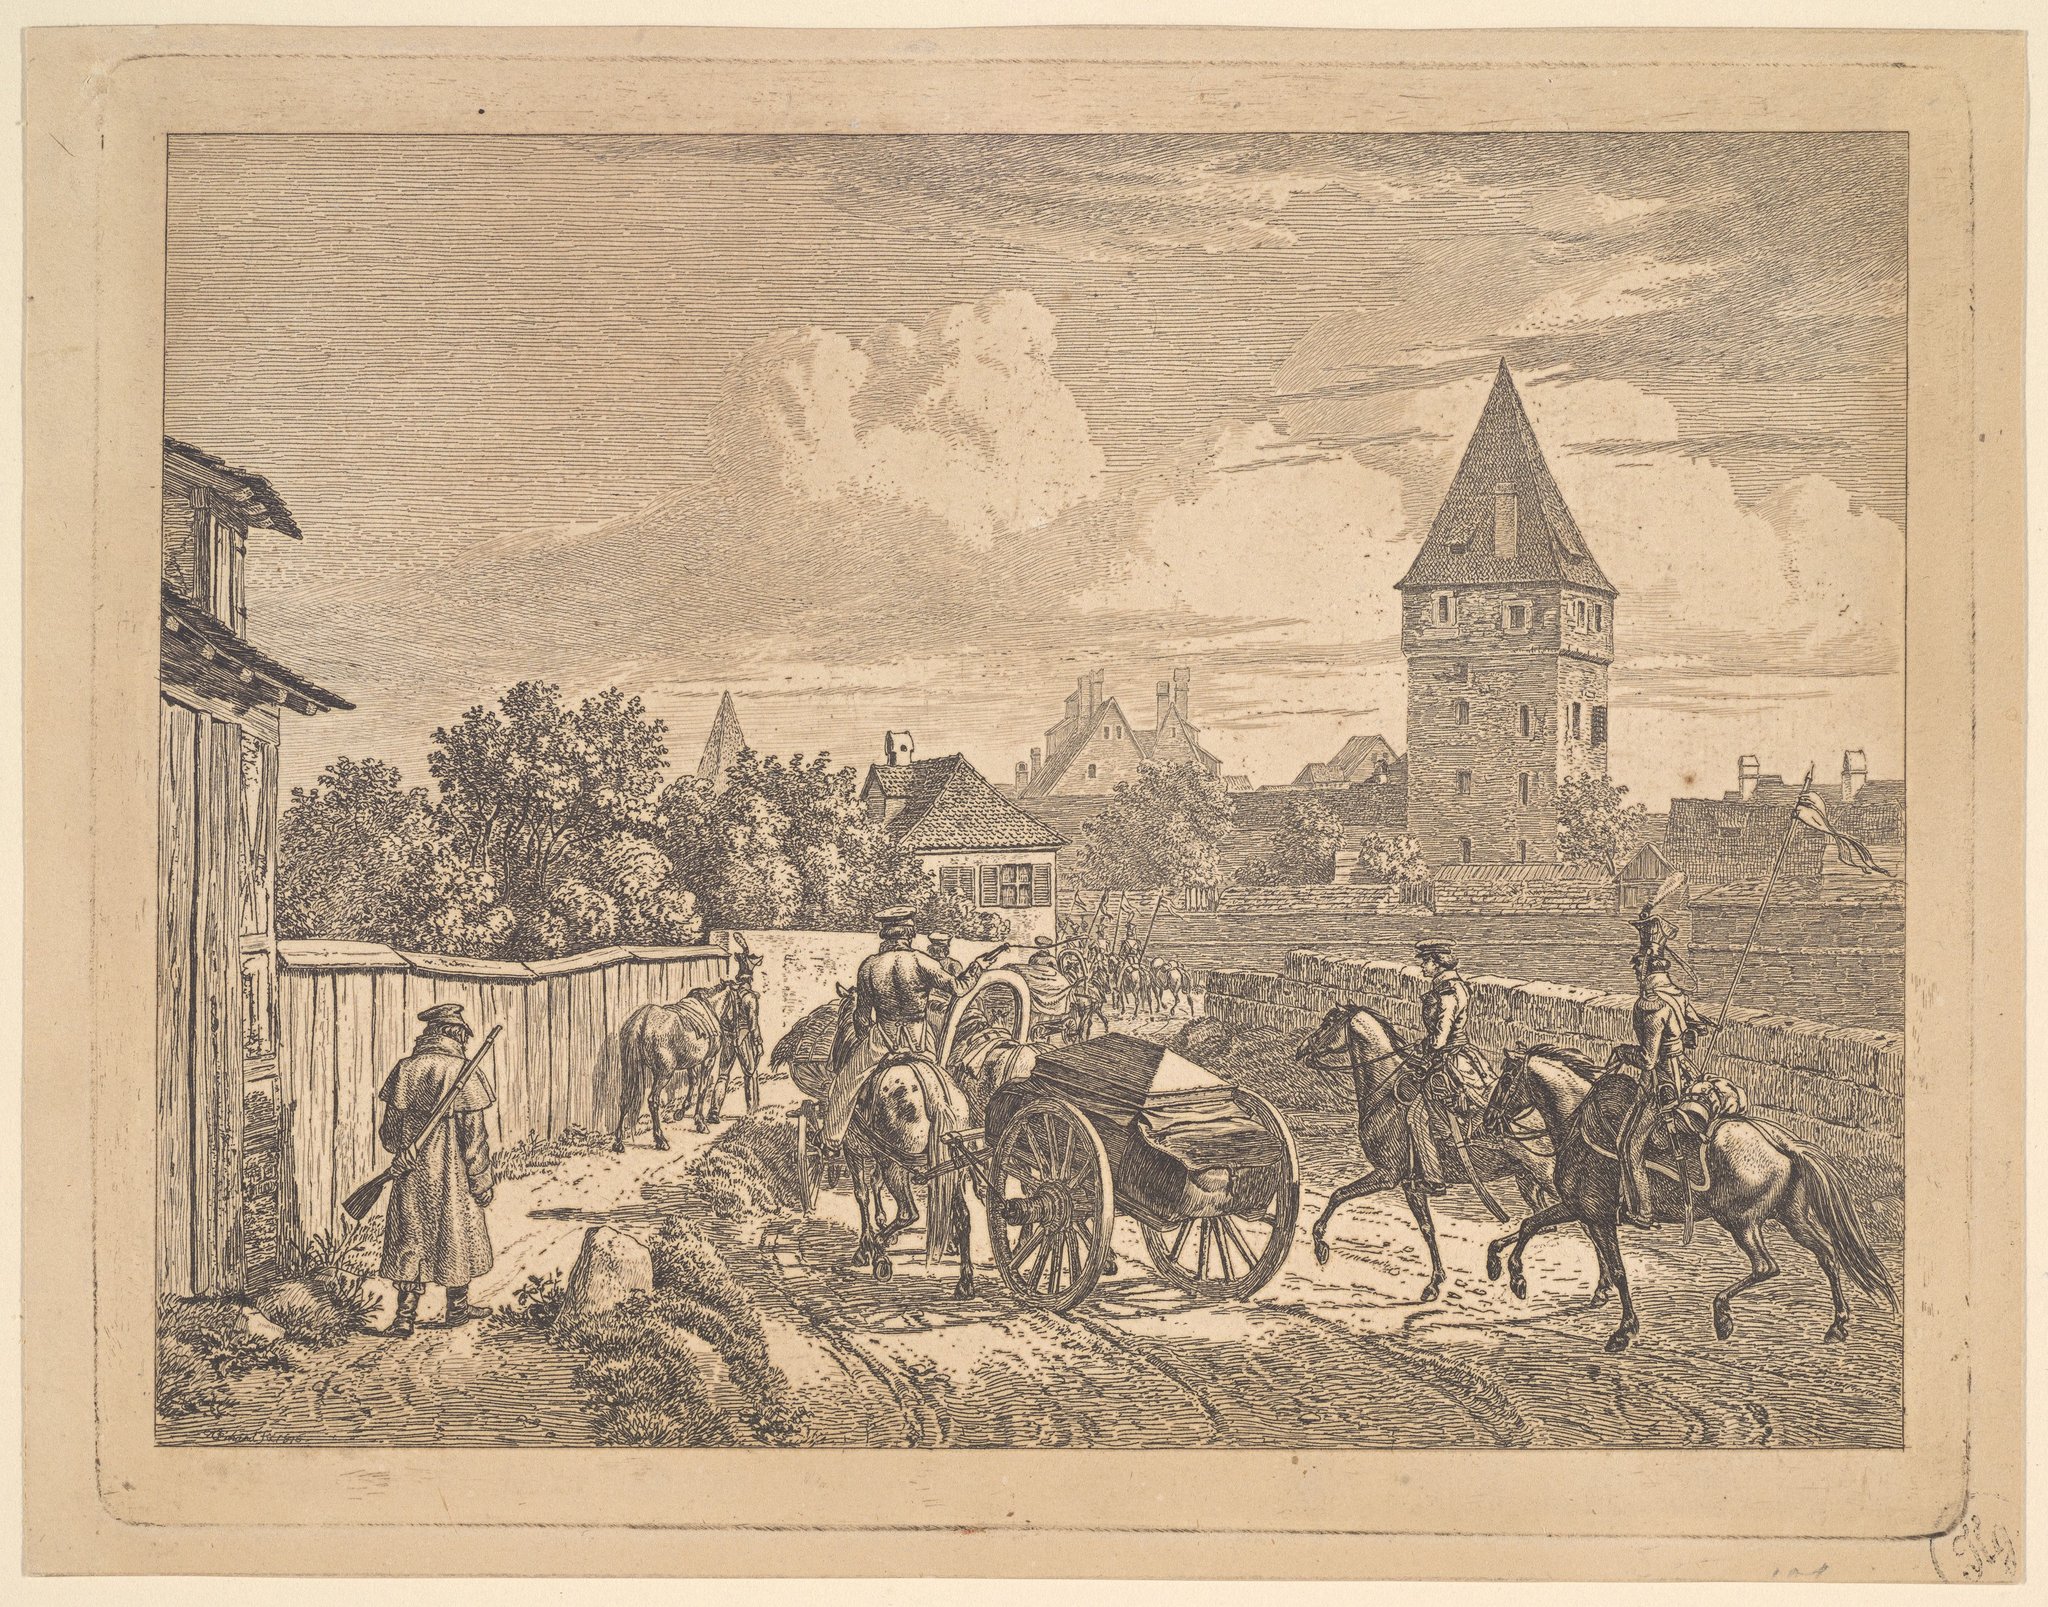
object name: print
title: Russian Lancers Escorting the Regimental Cassonne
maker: johann christoph erhard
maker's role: artist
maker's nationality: german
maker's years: 1795-1822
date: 1816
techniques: etching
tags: towers,men,horses